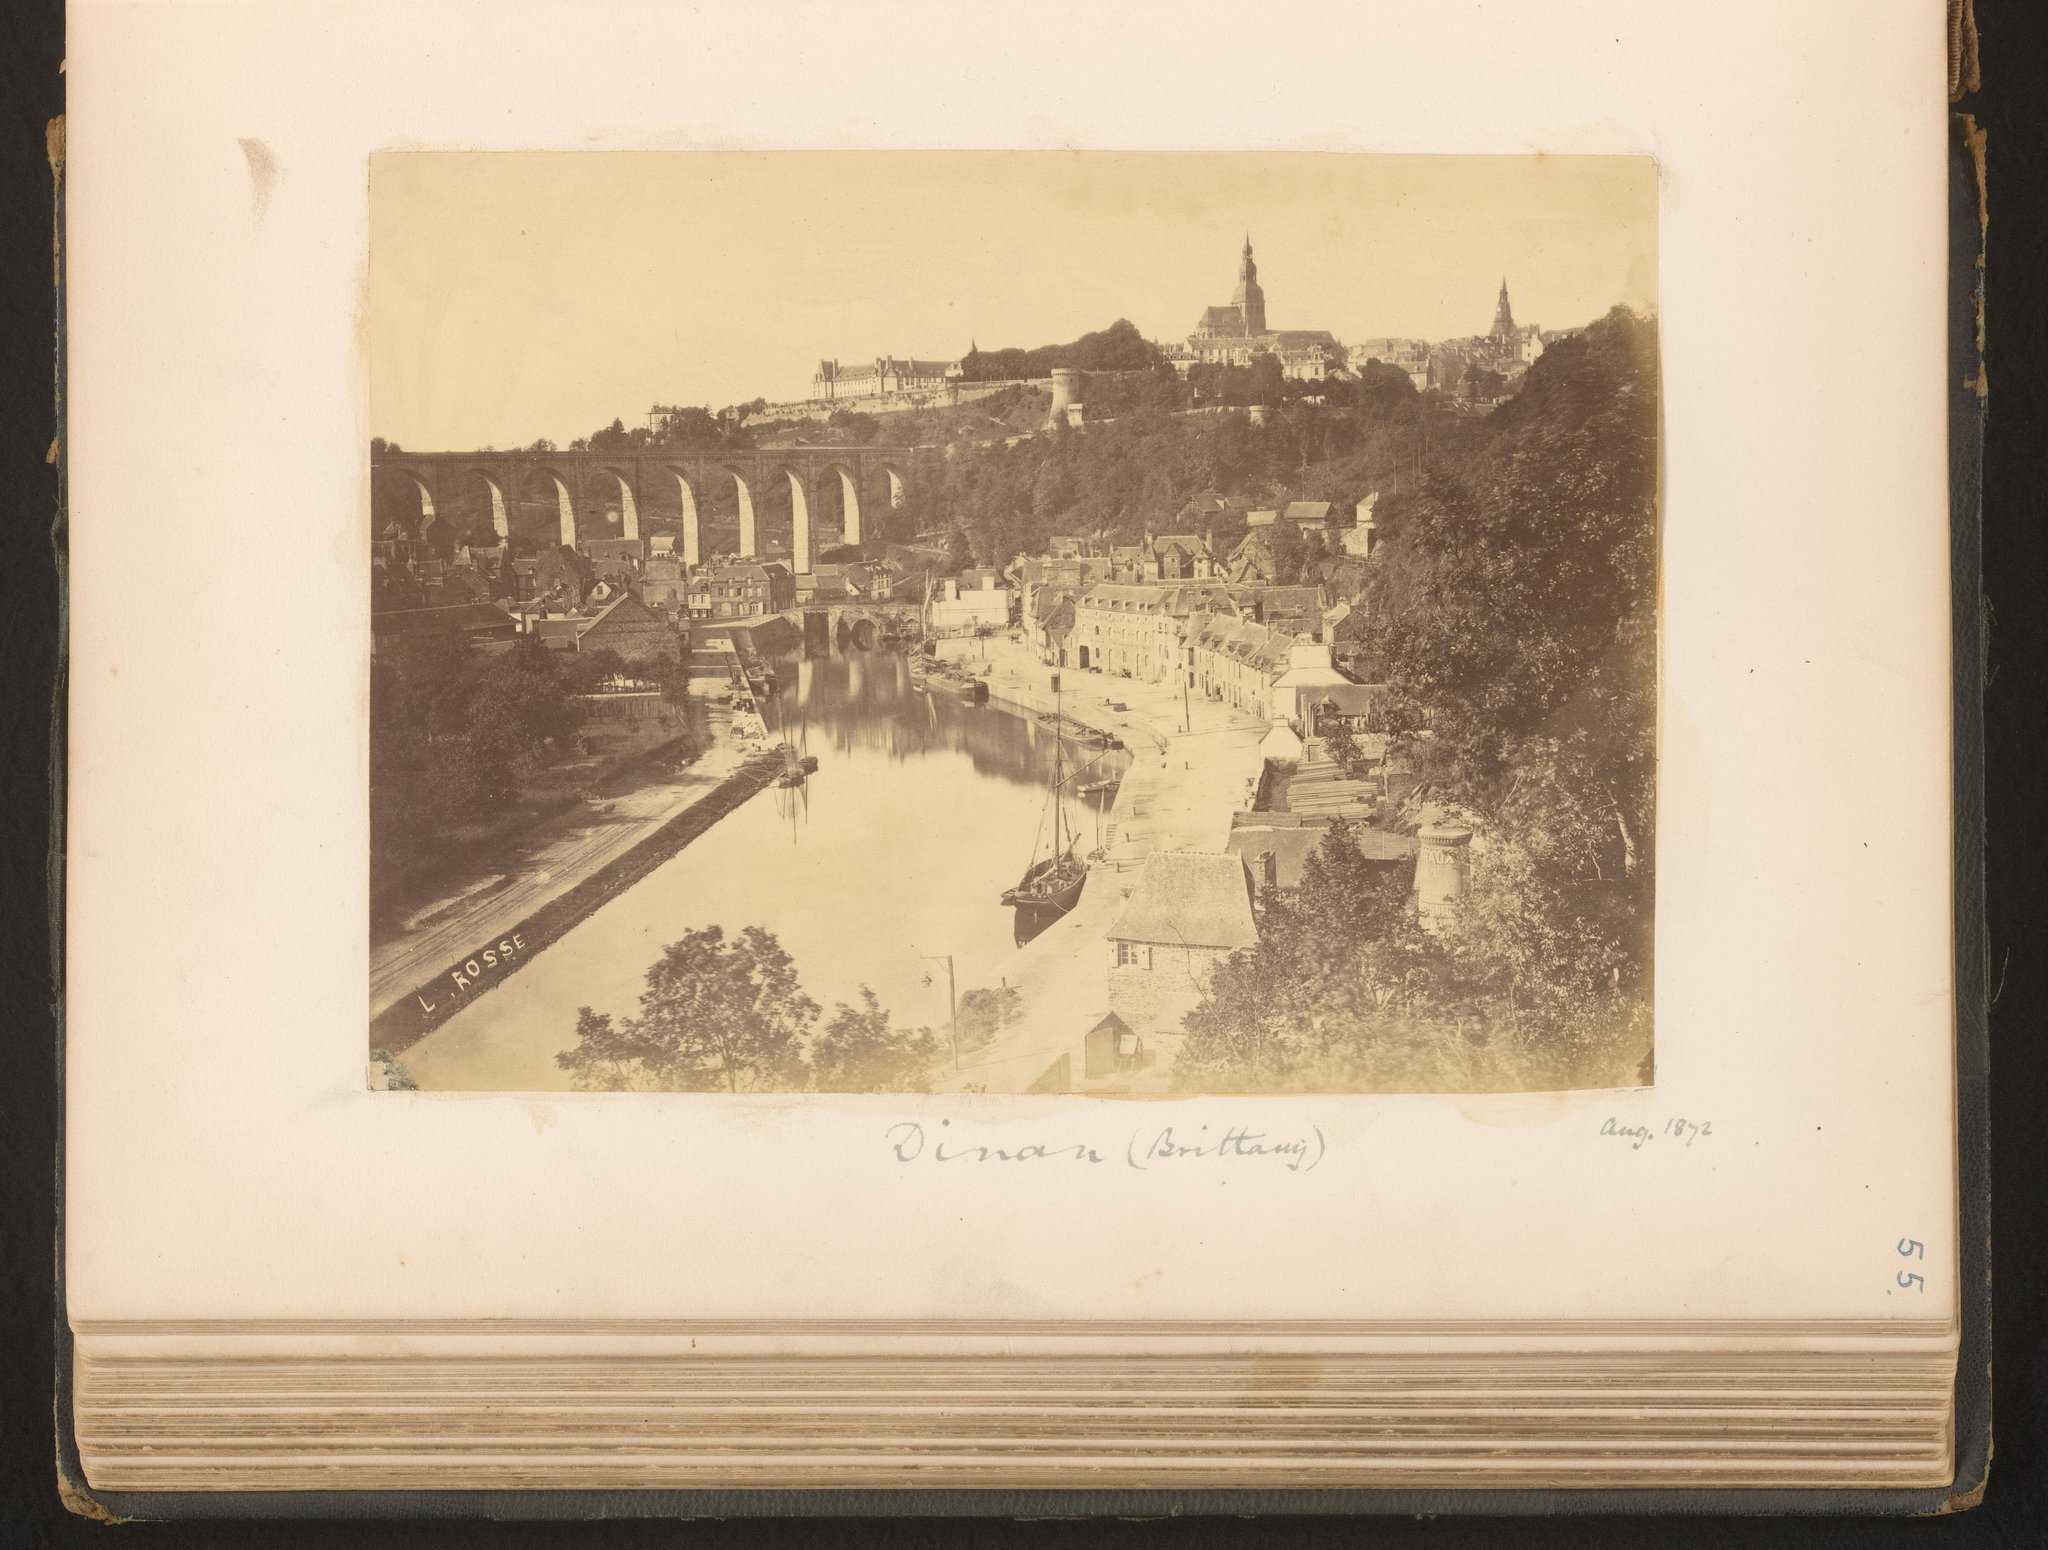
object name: photograph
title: Gezicht op Dinan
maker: Anonymous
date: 1808-1871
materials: paper, photographic support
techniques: albumen print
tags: viaduct, city-view in general; 'veduta', canals, waters (in city)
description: Deze pagina maakt deel uit van een album.